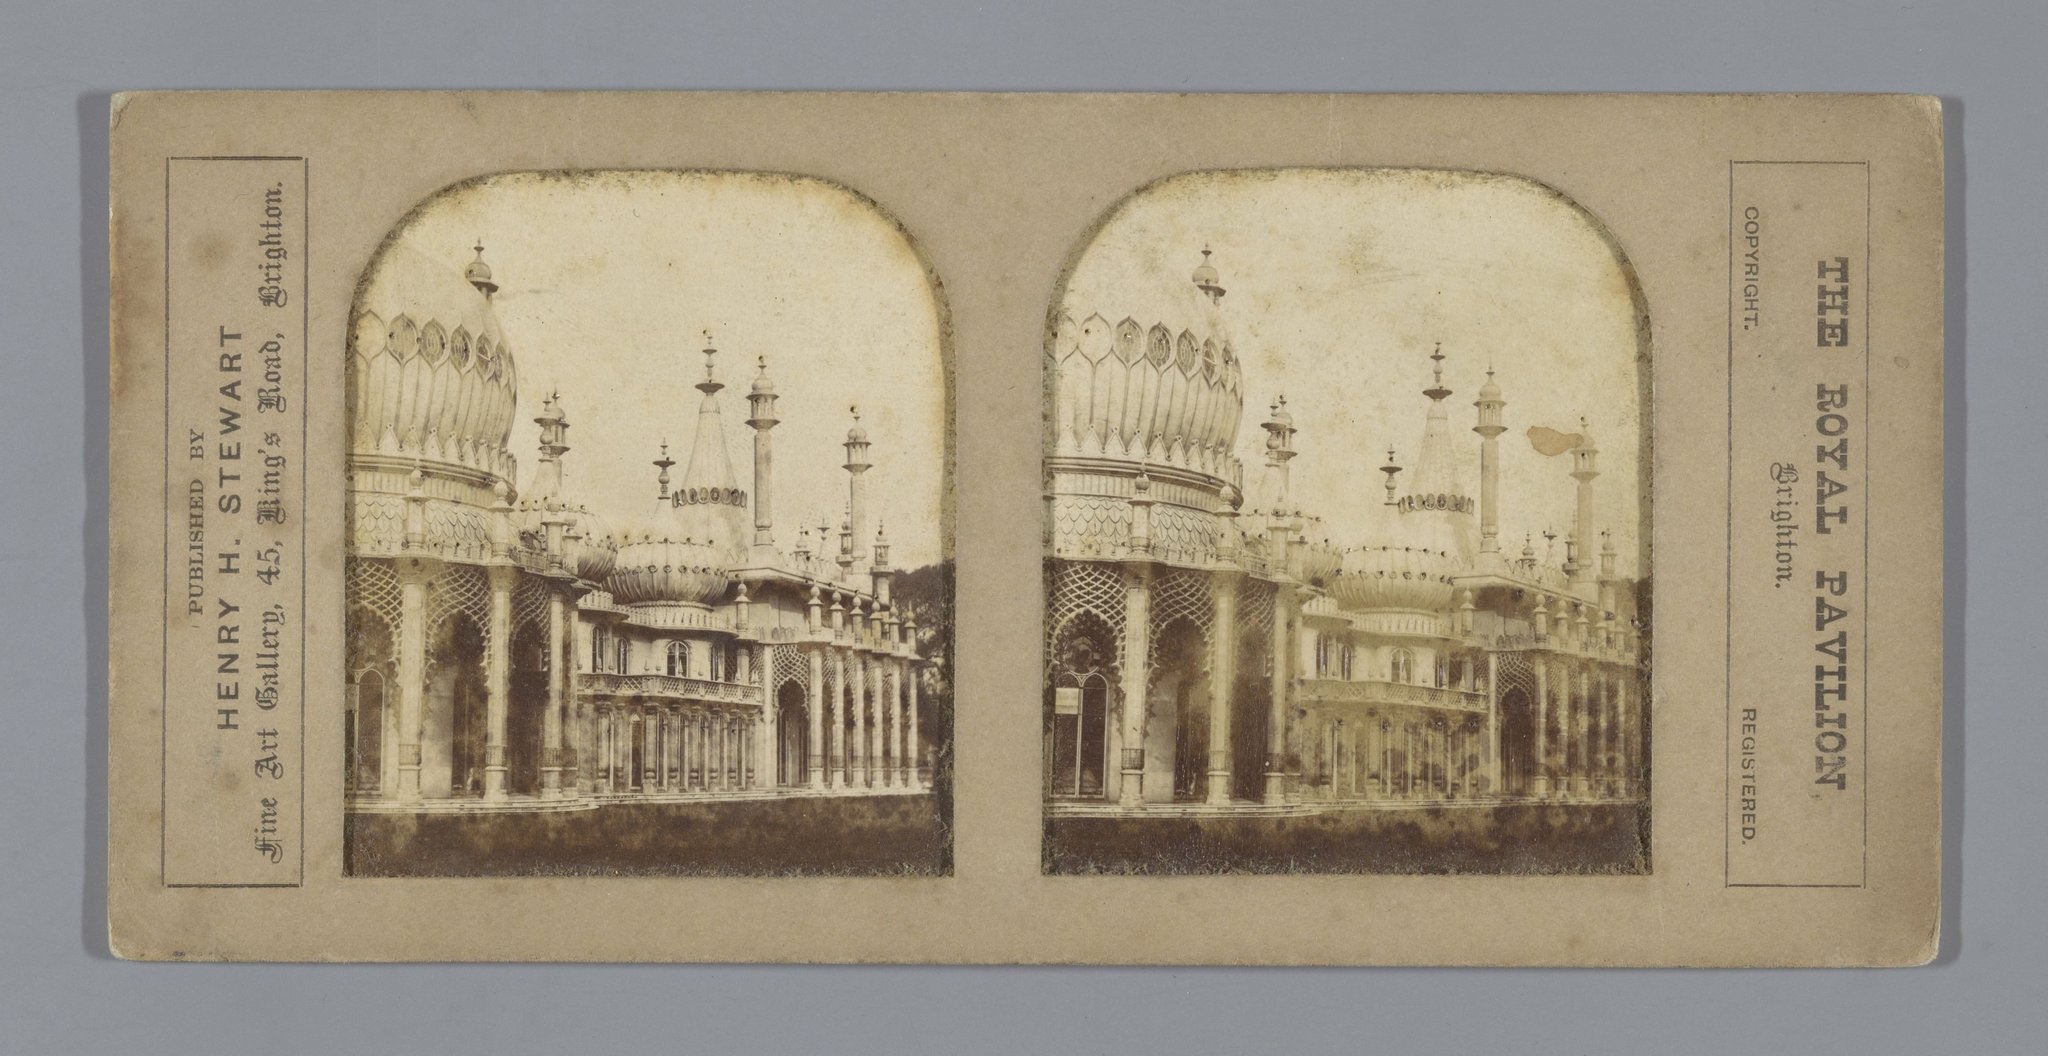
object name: tissue stereograph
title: Royal Pavilion in Brighton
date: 1855-1875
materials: cardboard, paper, photographic support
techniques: albumen print, hand coloring, perforating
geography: brighton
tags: palace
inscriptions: address: ‘Fine Art Gallery, 45, King's Road, Brighton’, copyright notice: ‘COPYRIGHT. REGISTERED.’